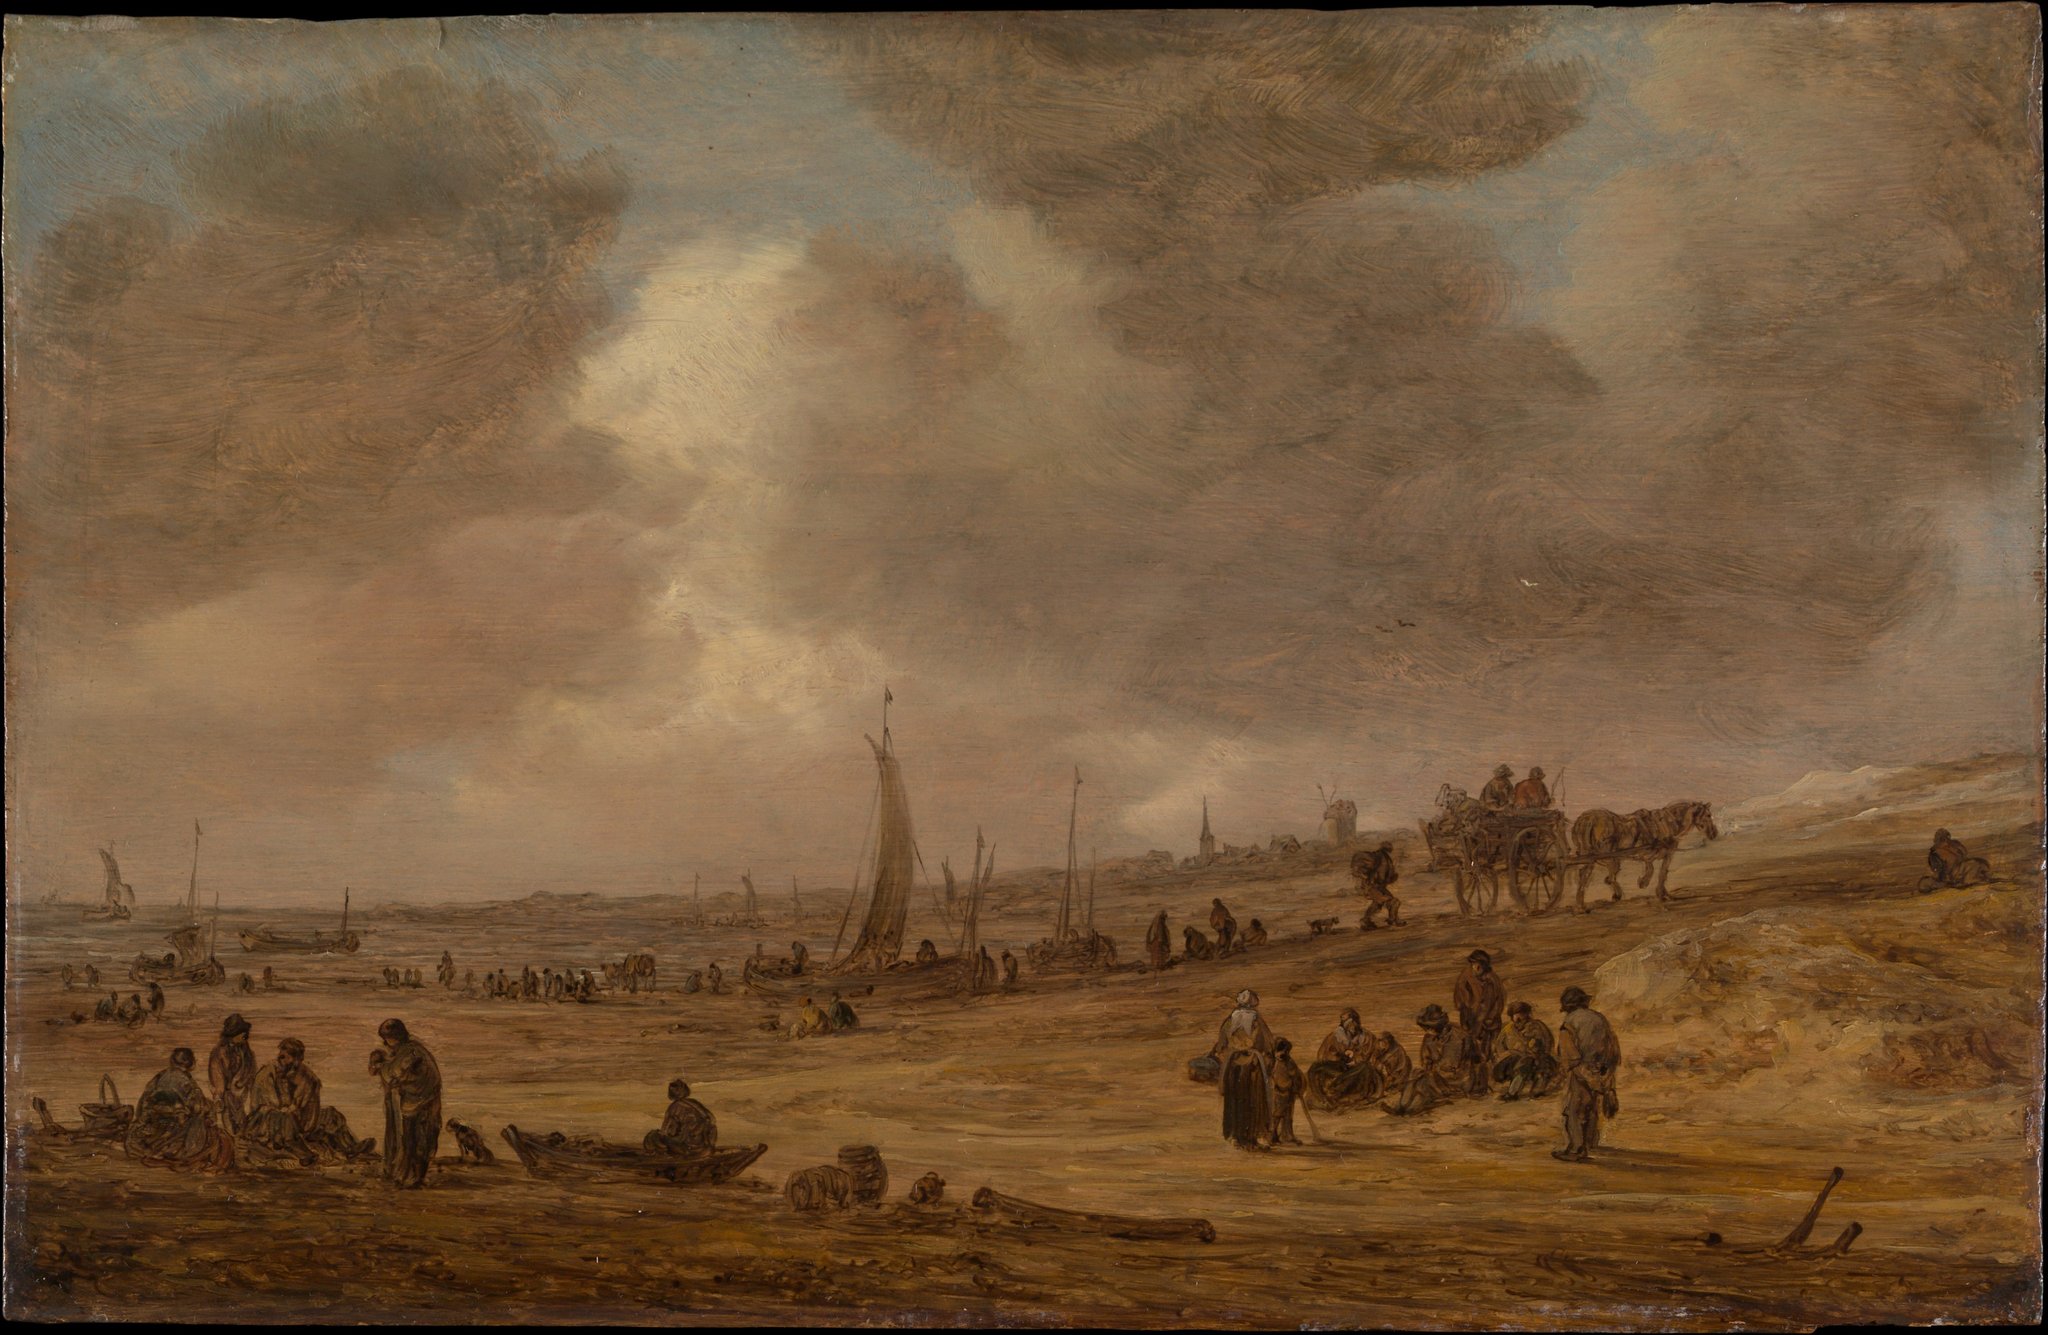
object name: painting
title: A Beach with Fishing Boats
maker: jan van goyen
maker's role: artist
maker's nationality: dutch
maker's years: 1596-1656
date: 1653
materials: oil, wood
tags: horses,beaches,boats,carts